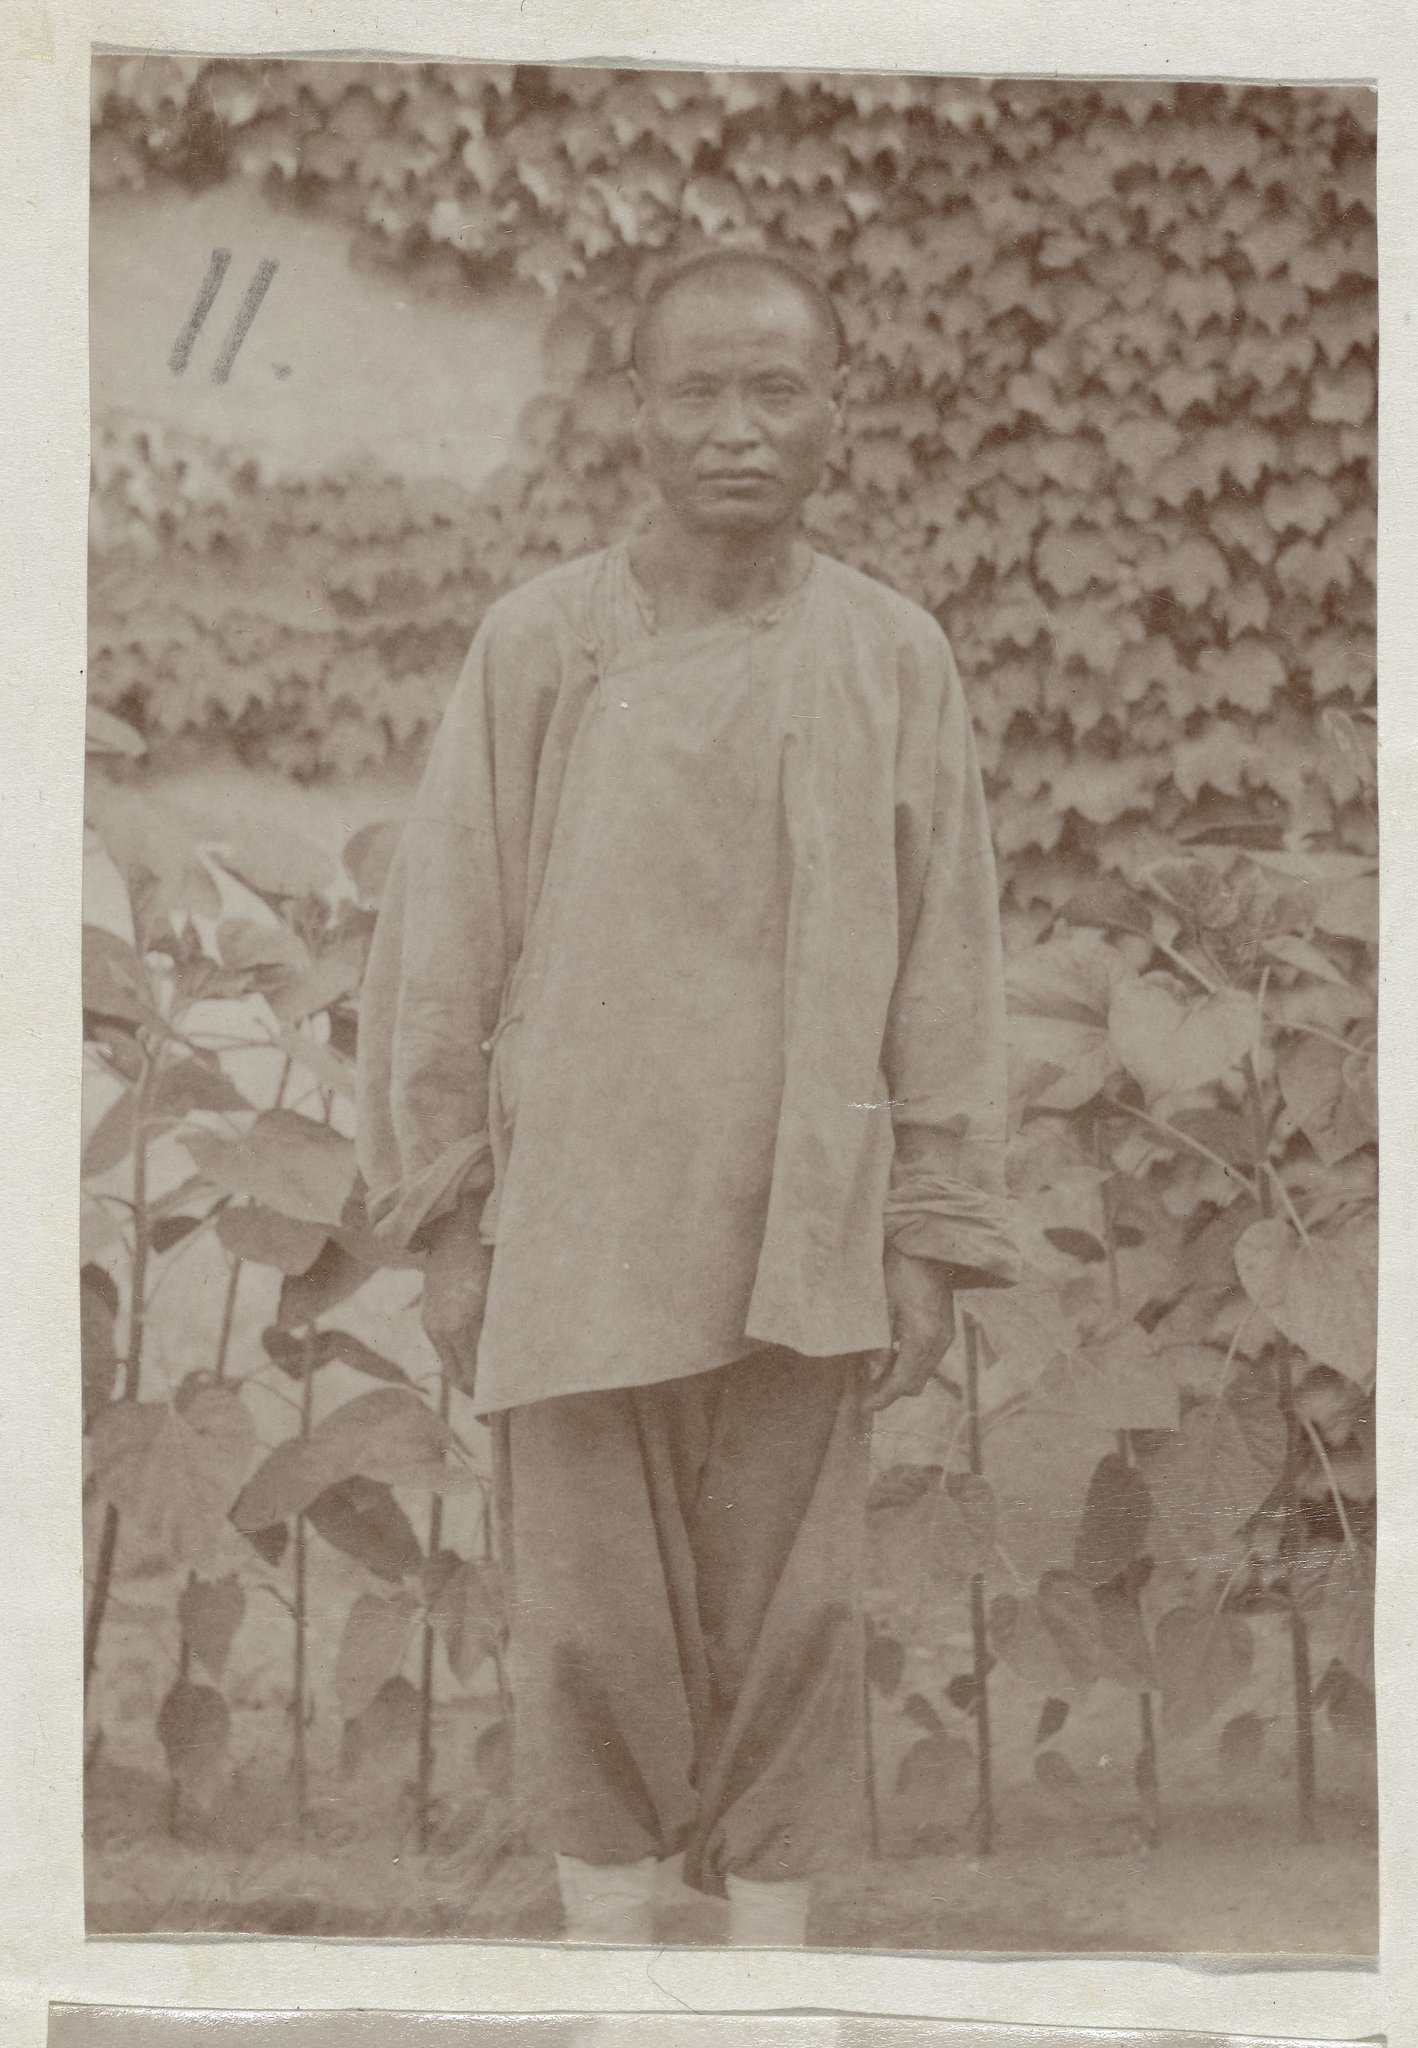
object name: photograph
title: Portret van een Chinese man in werkkleding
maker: Anonymous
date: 1879-1890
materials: paper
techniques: albumen print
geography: china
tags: historical persons not known by name, china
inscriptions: number: ‘11’